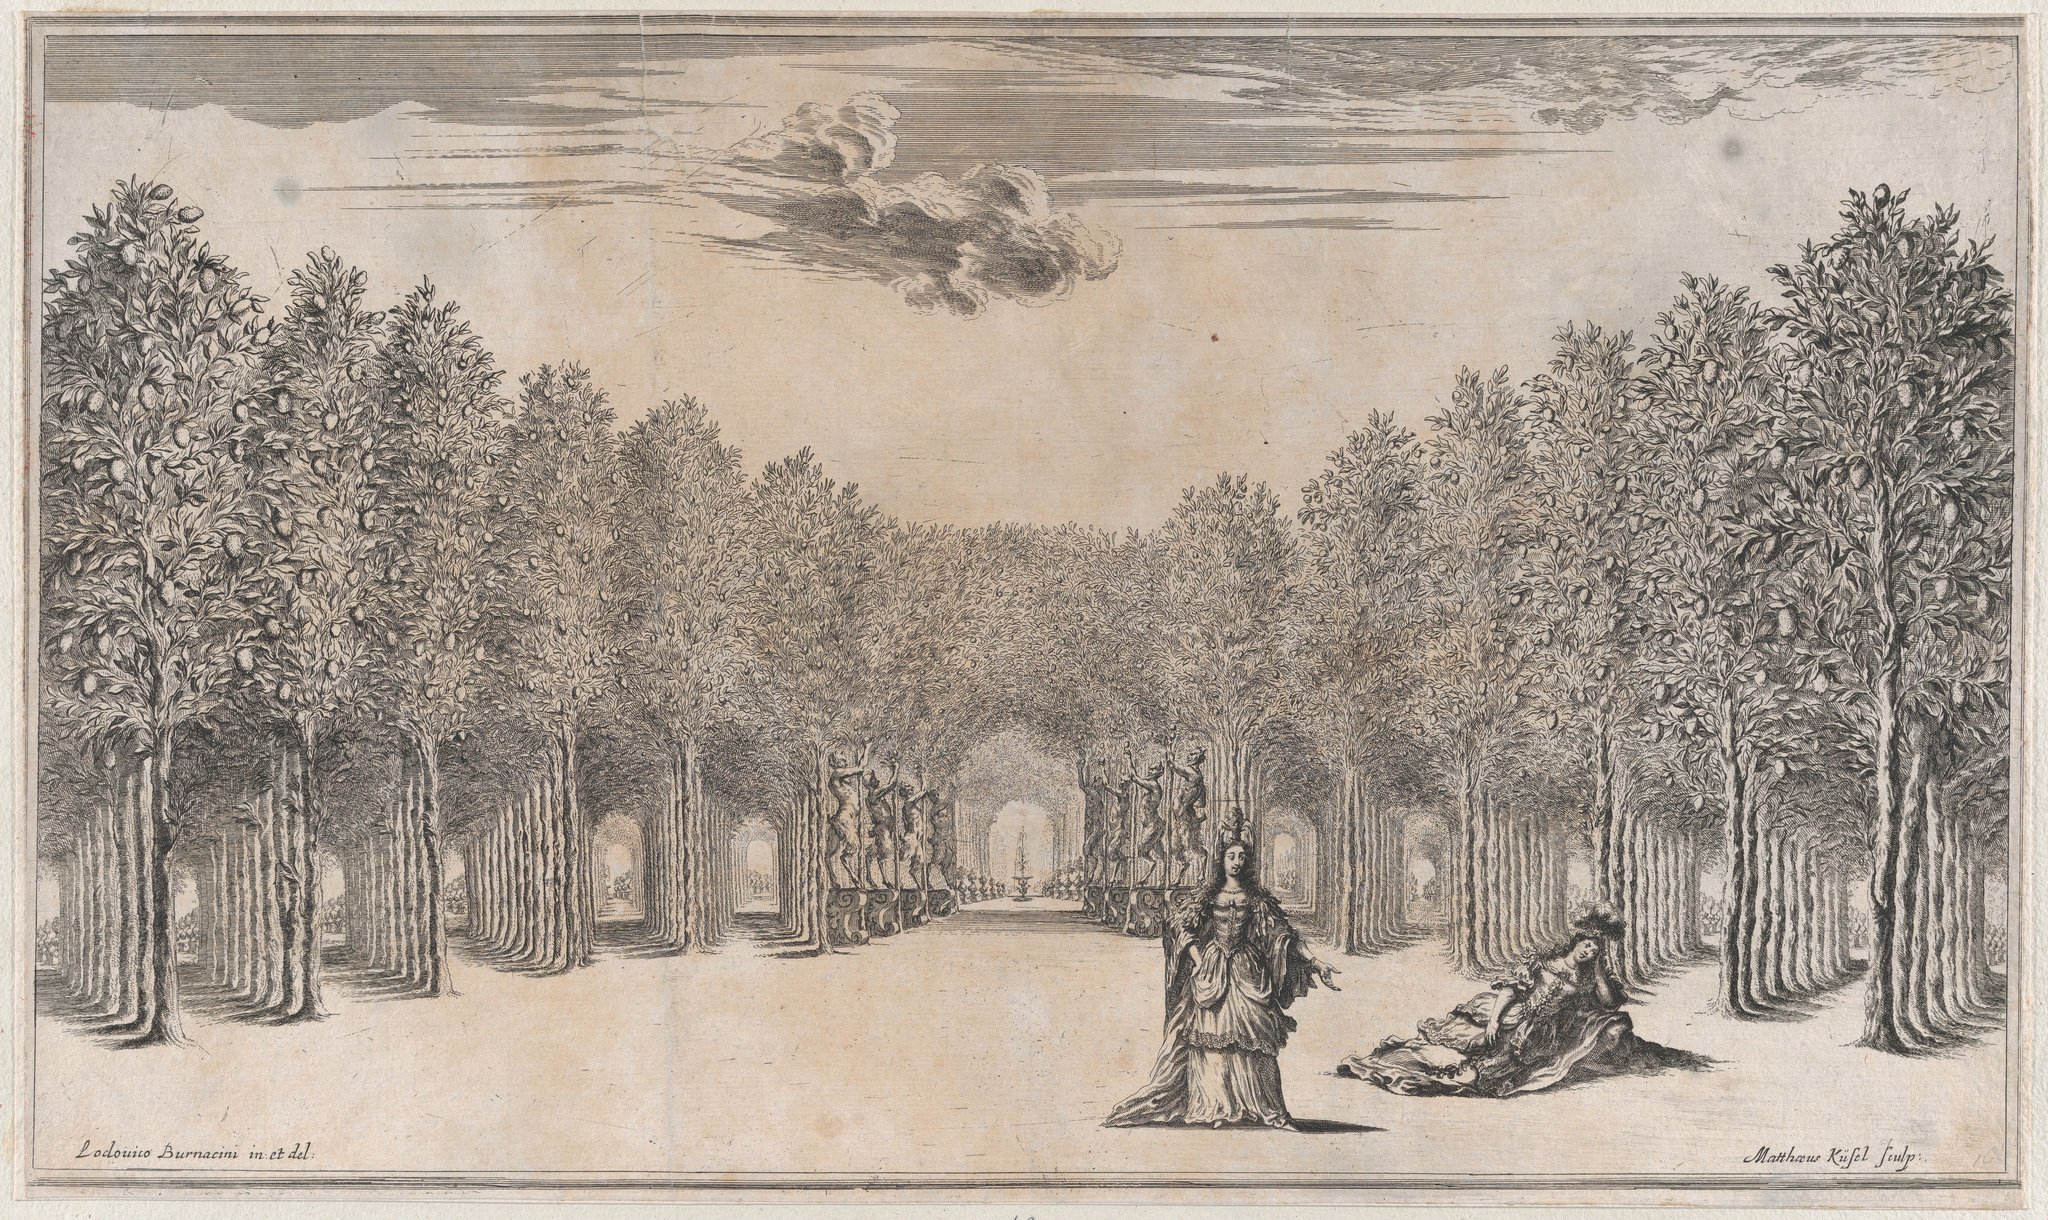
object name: print, fete, ornament architecture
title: Two females in the foreground, one standing the other reclining, surrounded by tree-lined paths; set design from 'Il Pomo D'Oro'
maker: mathäus küsel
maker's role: artist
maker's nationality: german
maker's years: 1621-1682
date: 1668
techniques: etching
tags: women,trees